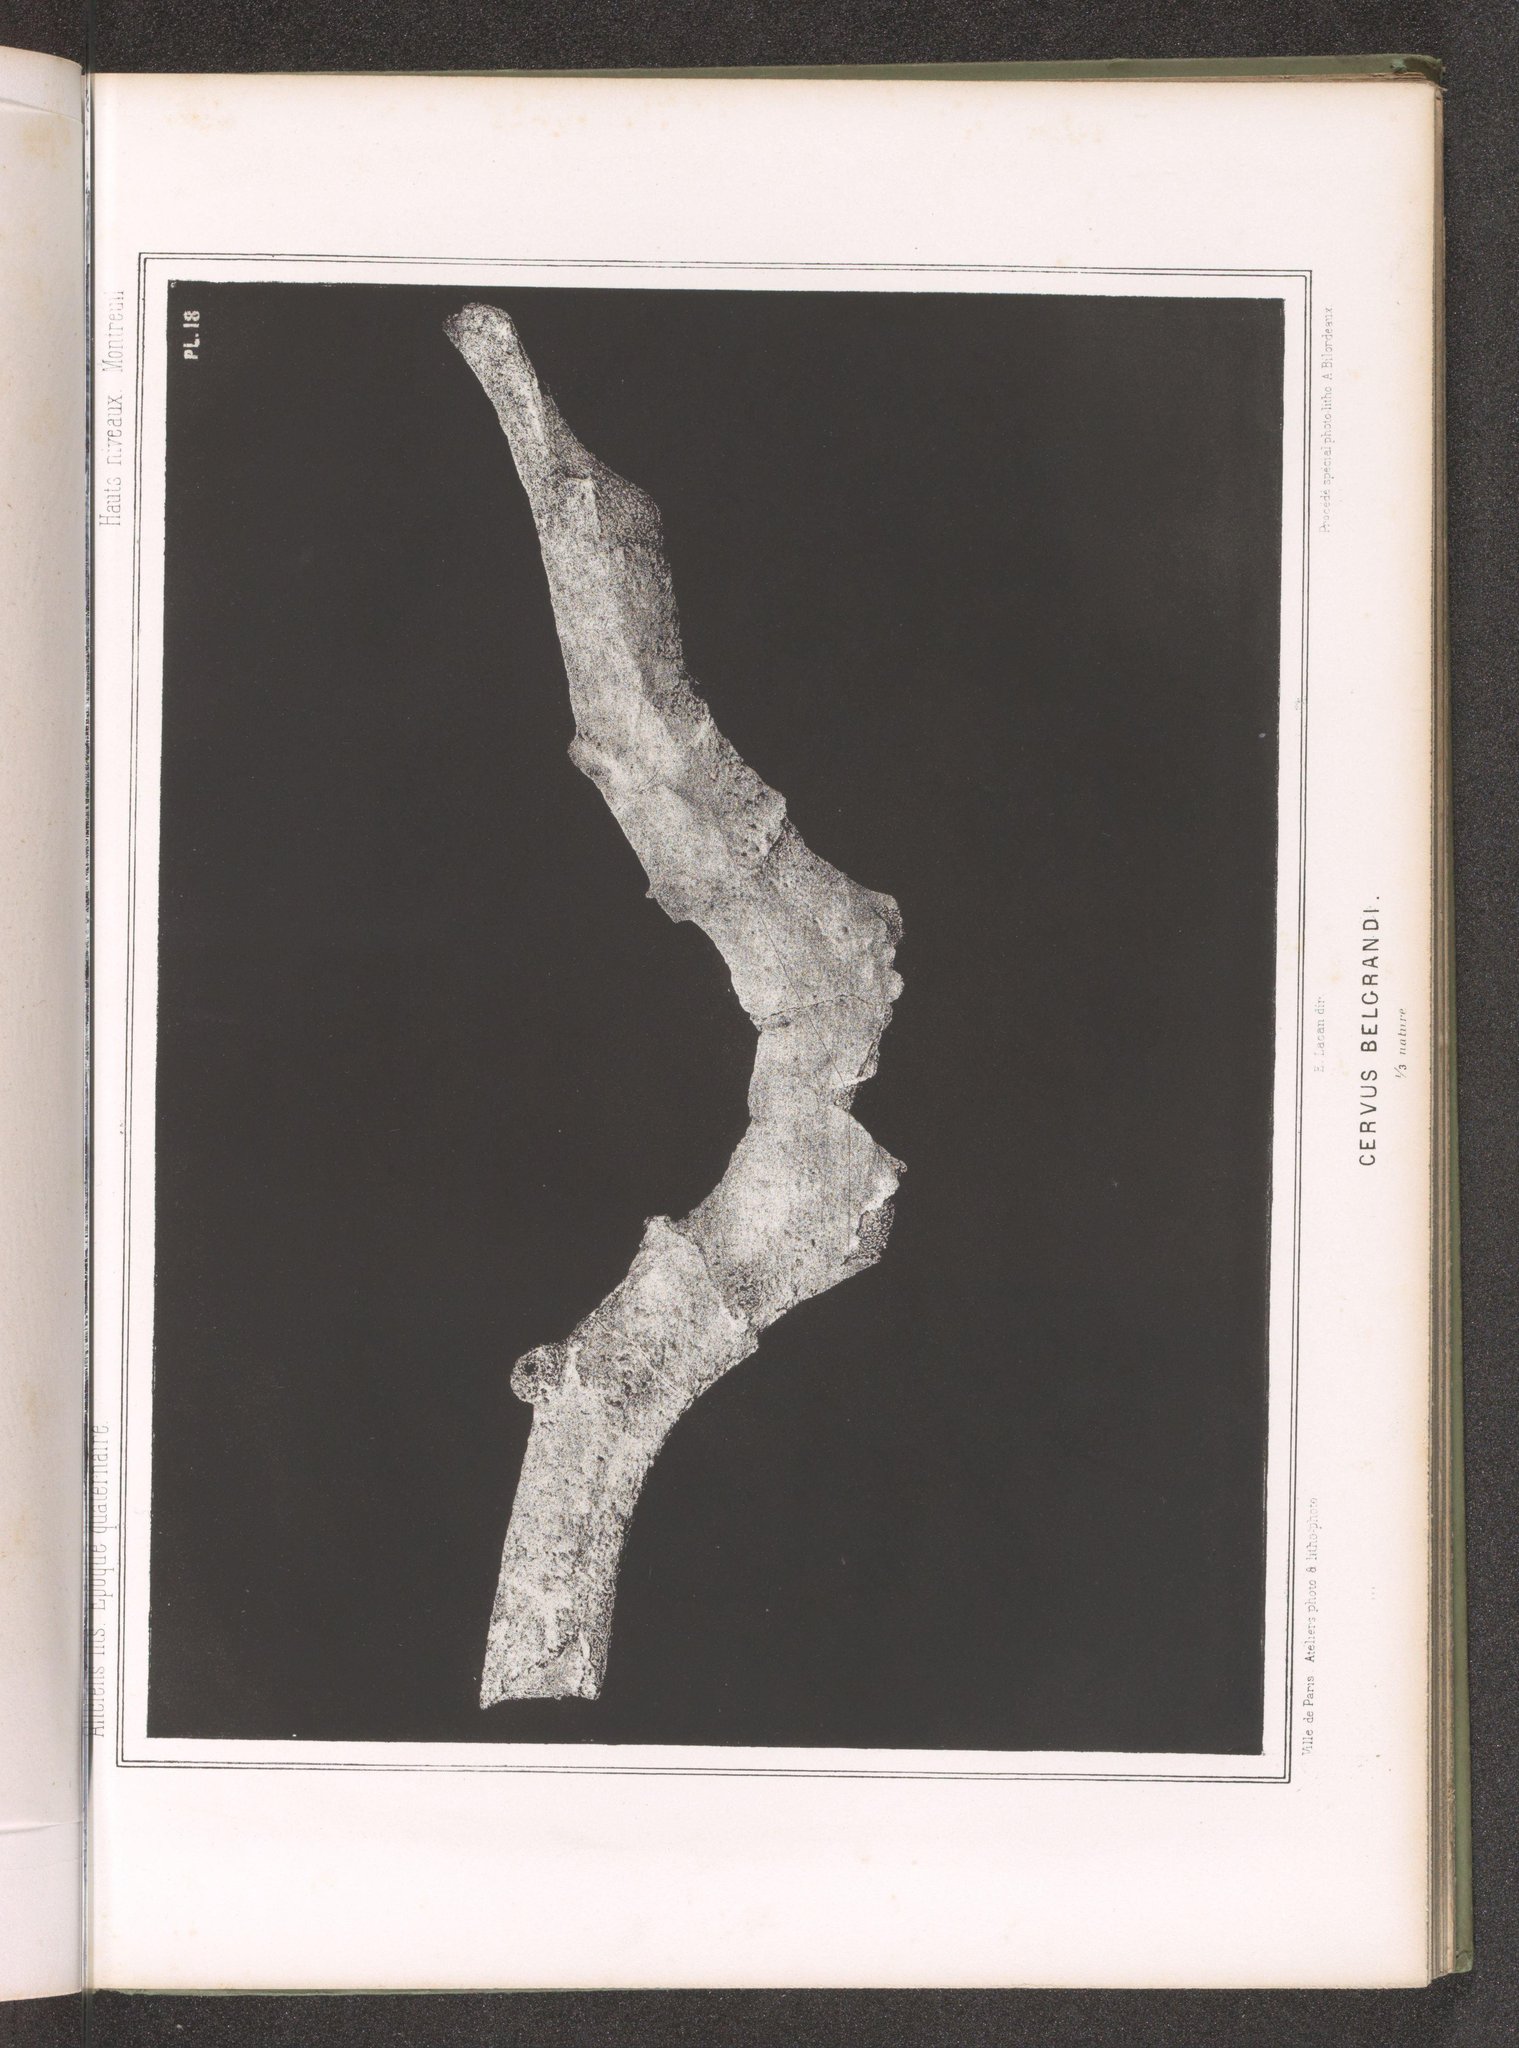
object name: page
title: Bot van een hert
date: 1860-1869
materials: paper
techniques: photolithography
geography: paris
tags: animals (+ skeleton of an animal), palaeontology, france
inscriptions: number: ‘Pl. 18’, monogram: ‘AB’, inscription: ‘Ville de Paris Ateliers photo & litho-photo. E. Lacan, dir. Procédé spécial photo-litho A. Bilordeaux’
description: Voor plek prent in boek: zie nummer onder 'Opschriften / Merken'.